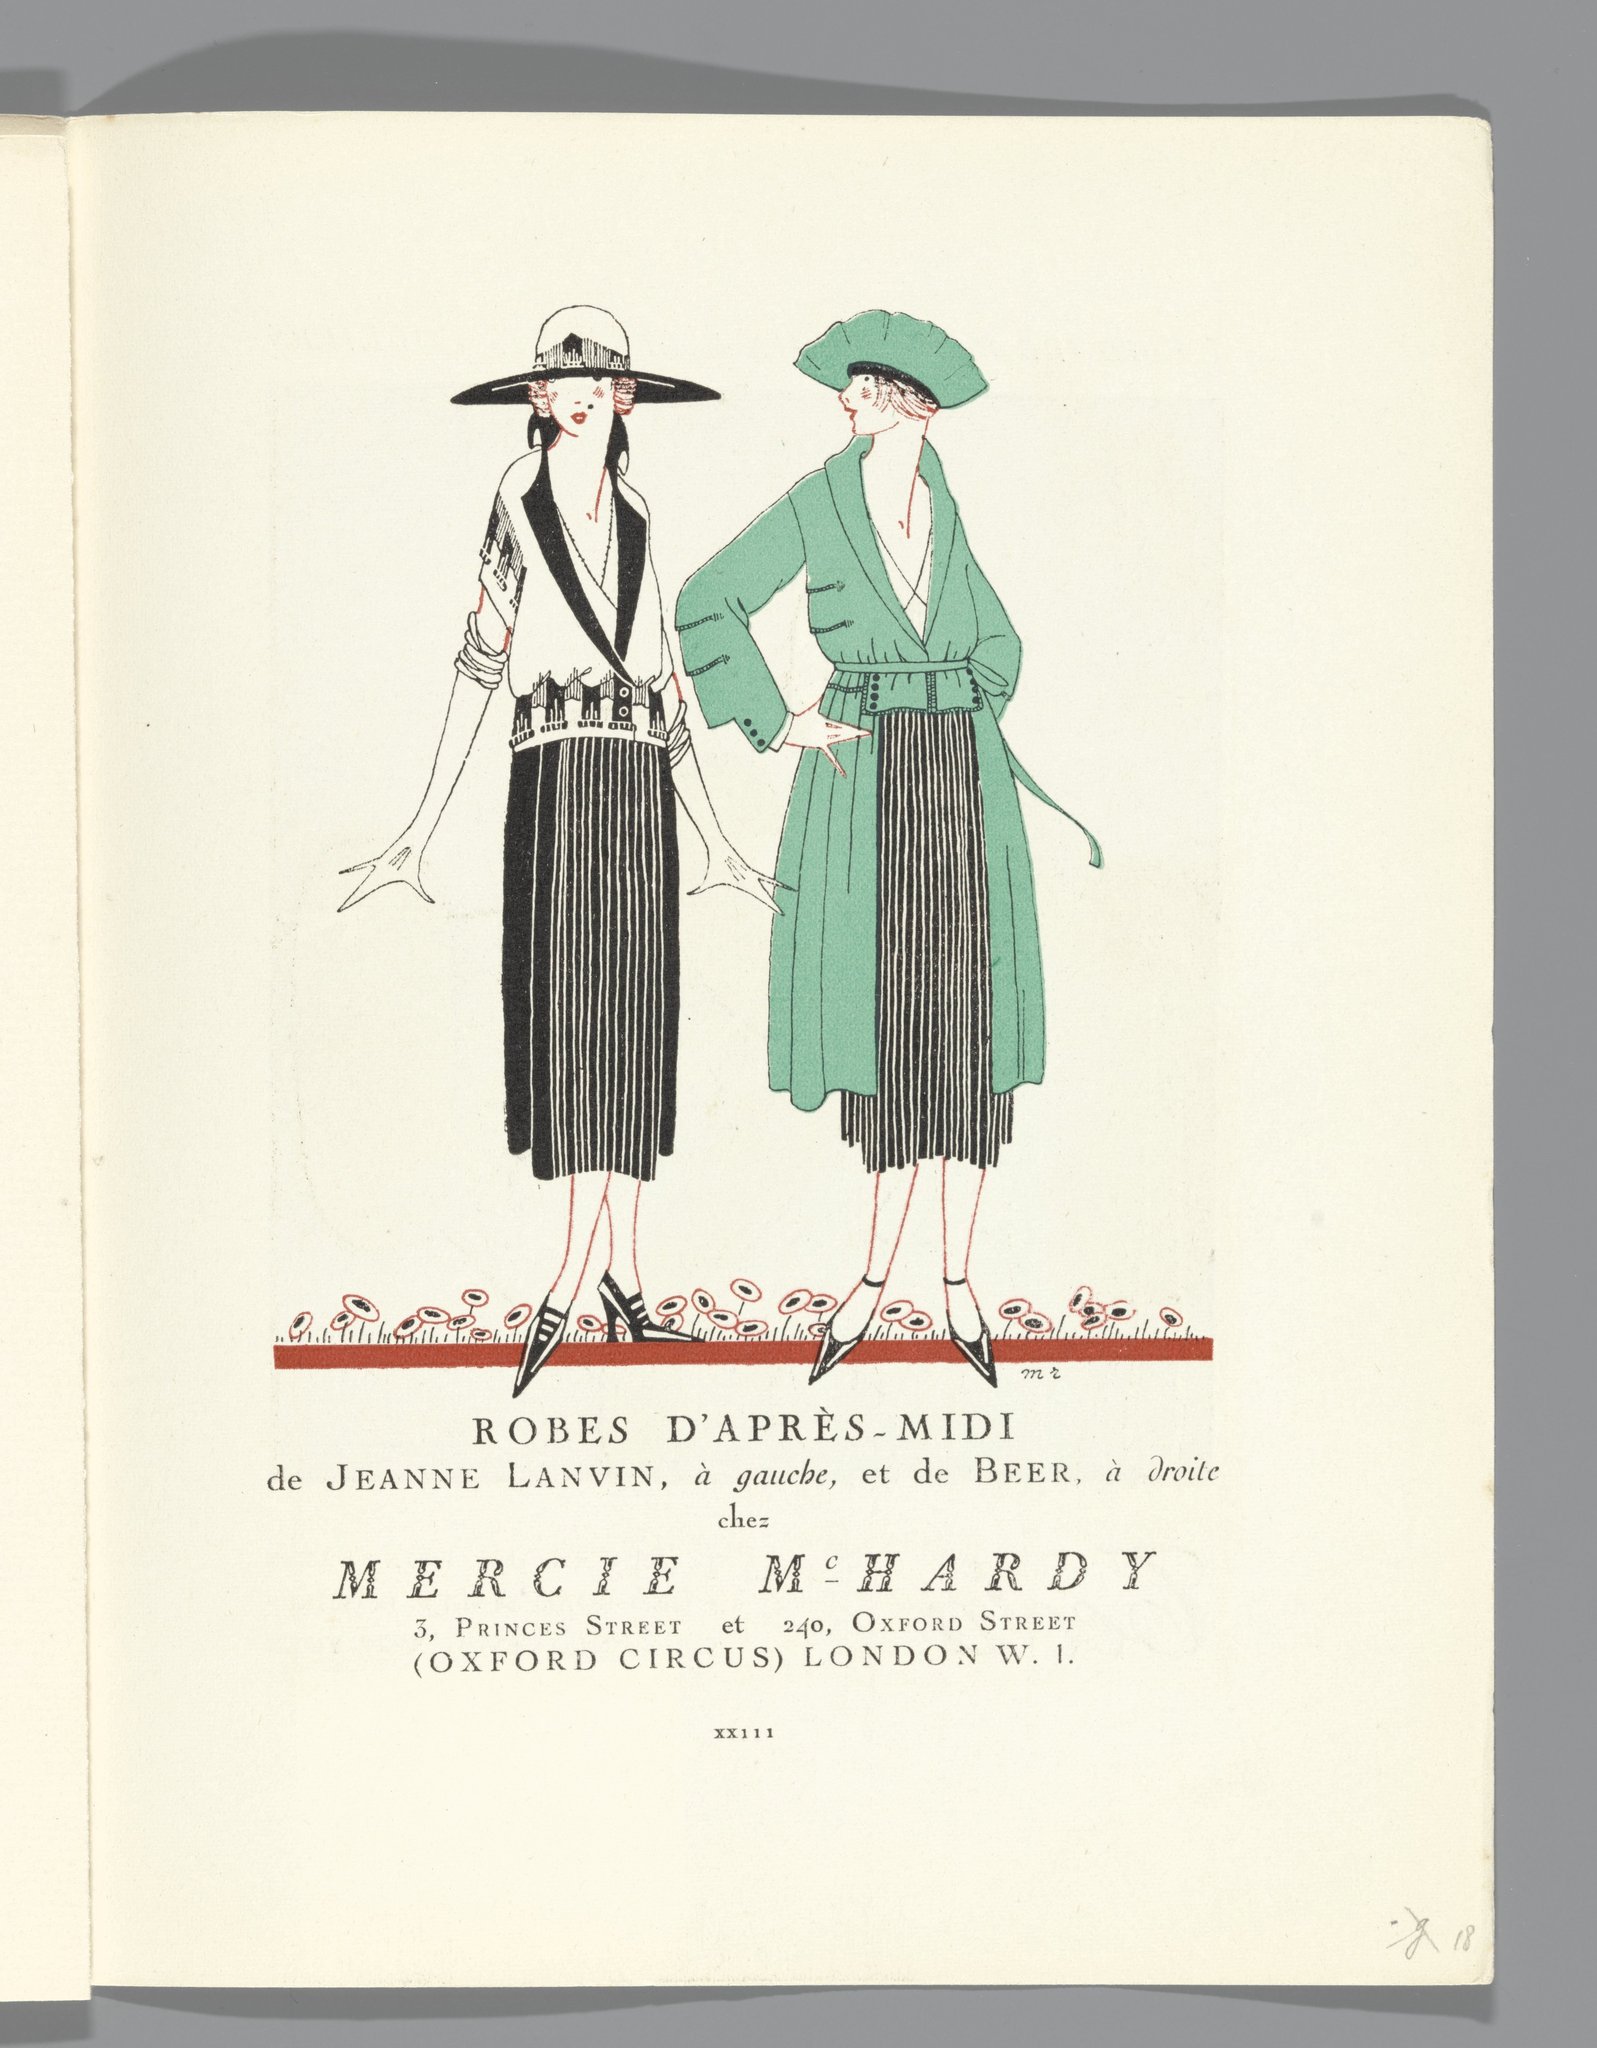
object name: fashion print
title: Gazette du Bon Ton, 1920 - No. 3, p. XXIII: Robes d'après-midi de Lanvin et Beer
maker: lucien vogel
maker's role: publisher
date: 1920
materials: paper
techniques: lithograph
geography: geneva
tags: dress, gown (afternoon dress) (+ women's clothes), fashion plates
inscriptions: date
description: Advertentie van Mercie McHardy, Oxford Street, Londen: links een japon van Jeanne Lanvin, rechts een japon en mantel van Beer.